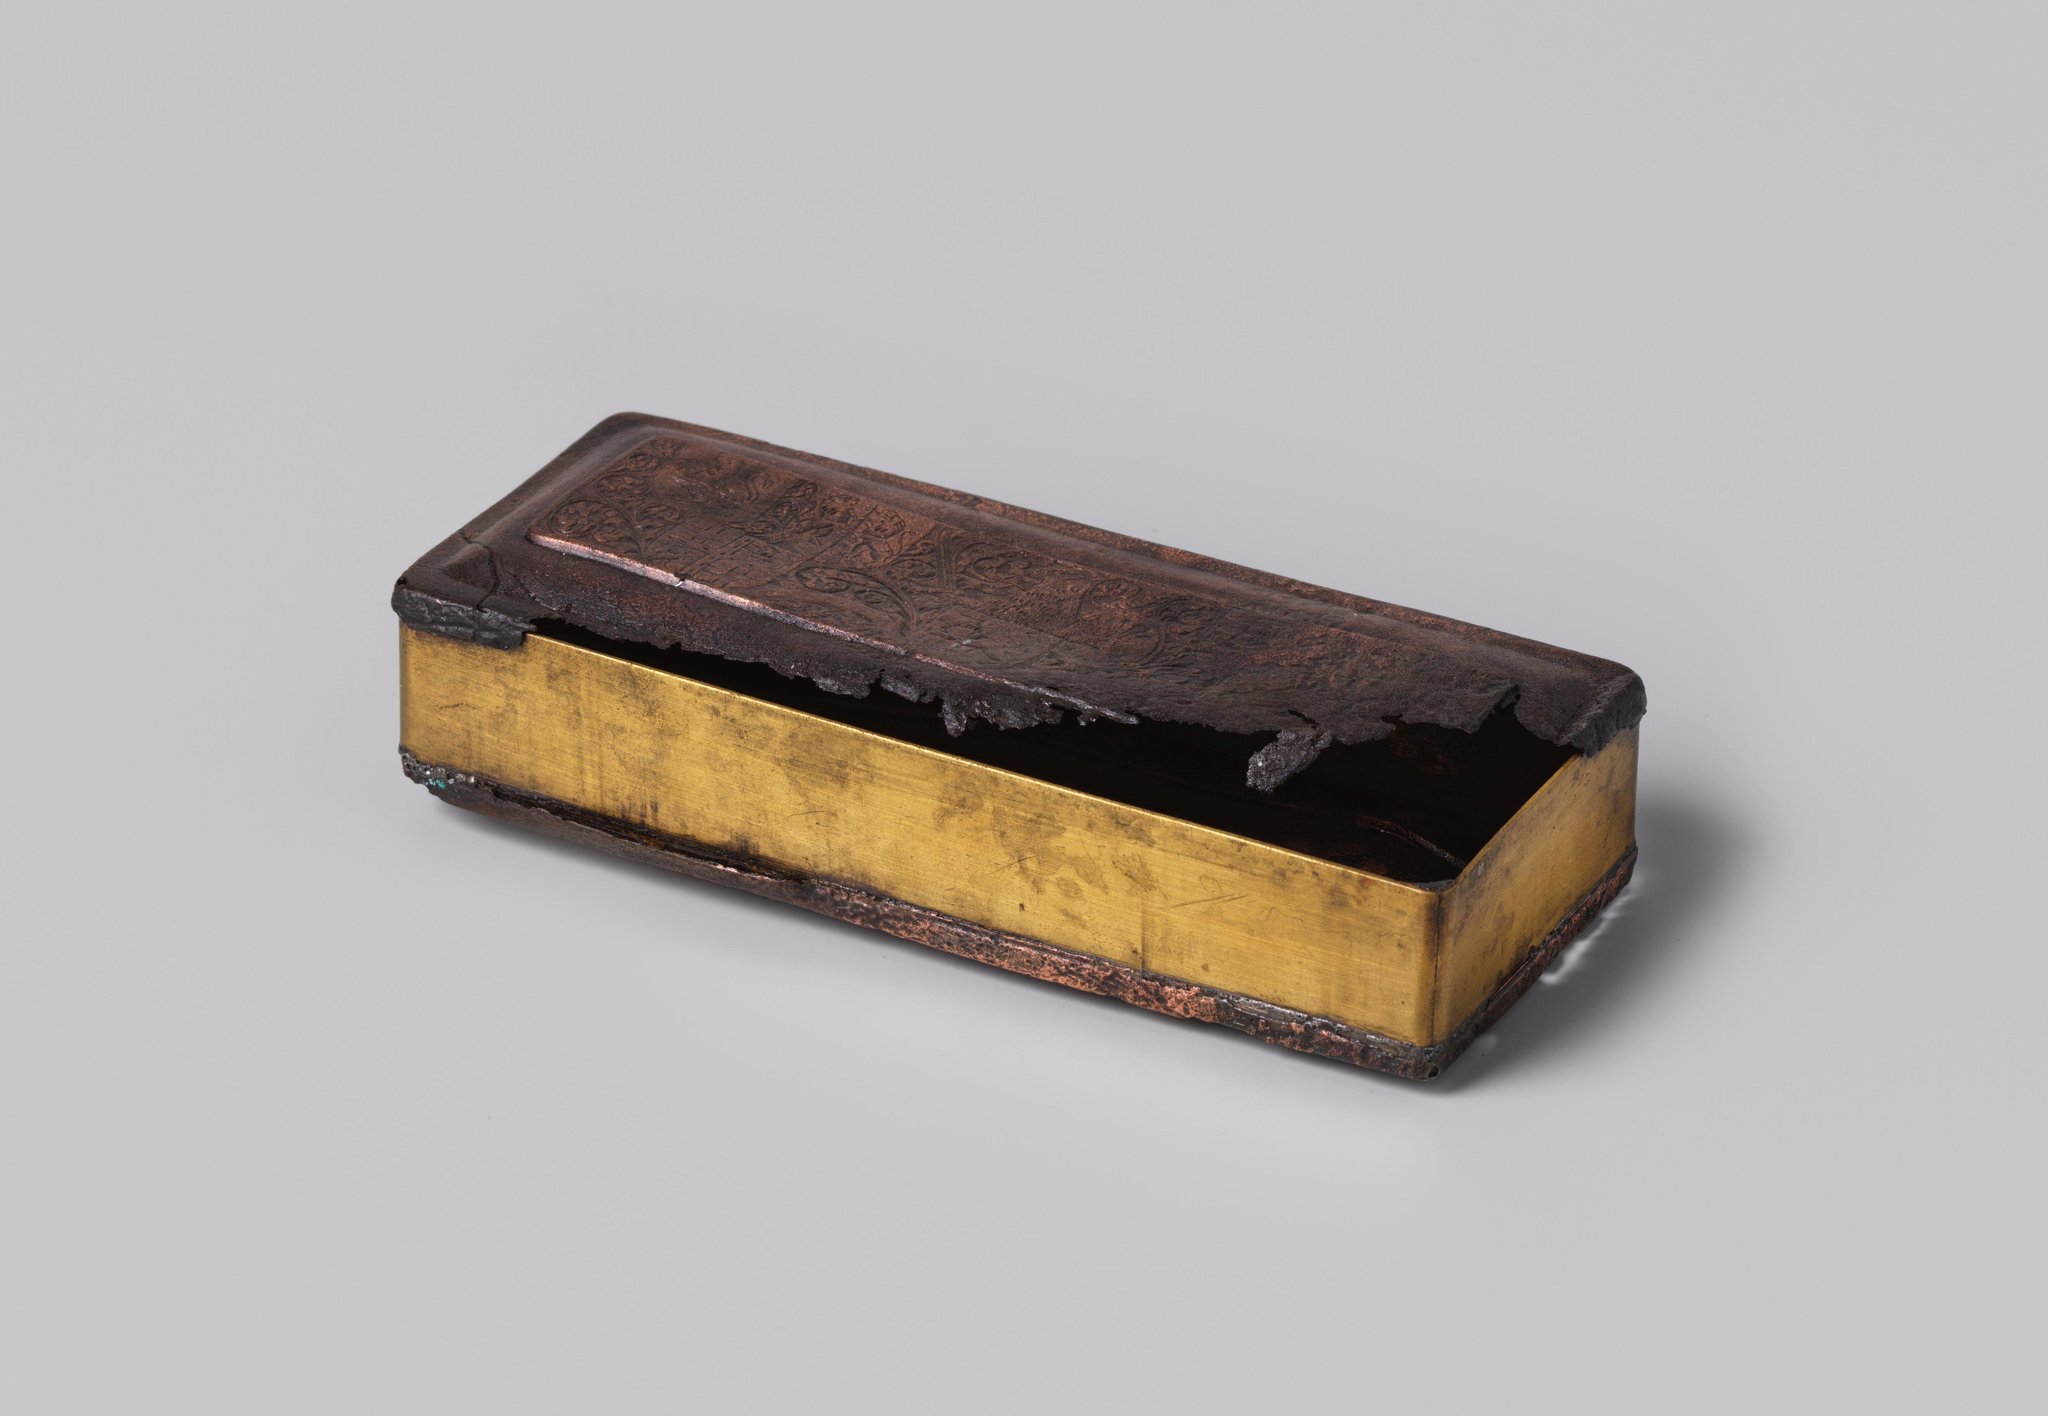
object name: tobacco box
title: Tabaksdoos uit het wrak van de Oost-Indiëvaarder Hollandia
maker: Anonymous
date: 1700-1743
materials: copper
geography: netherlands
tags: verenigde oostindische compagnie, hollandia (schip), annet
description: Tobacco box; box with lid, eroded: rectangular oblong, flat, lid and underside engraved: on lid a lion rampant with bundle of arrows enclosed by 7 coat of arms [of the United Provinces] and scrolling foliage: on underside a central panel with scene of seated man and nude woman with a veil, on either side a bird and scrolling foliage.